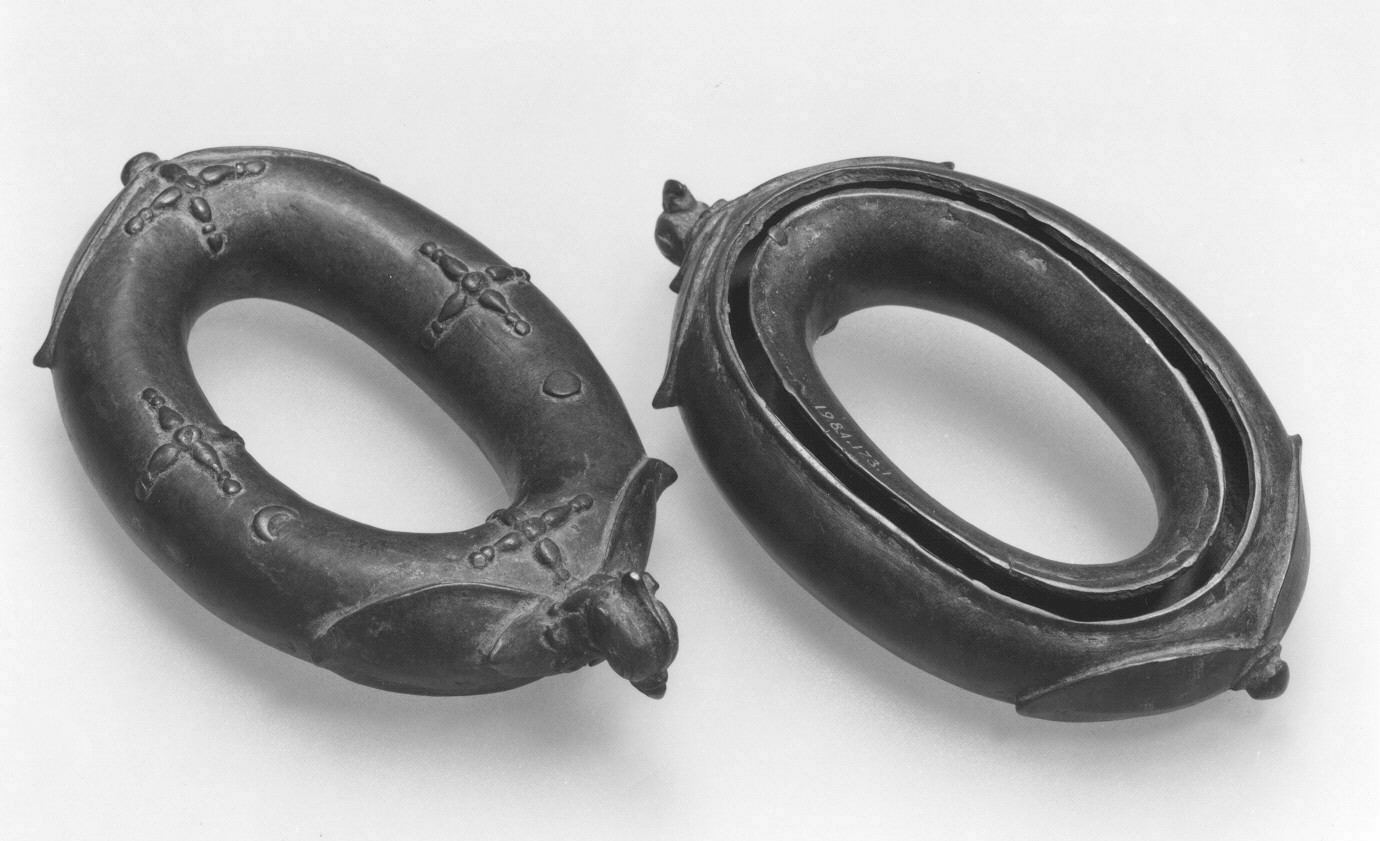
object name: kaichiliambu vessel rattle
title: Kaichiliambu (vessel rattles)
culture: indian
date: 1801-1900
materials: bronze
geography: india